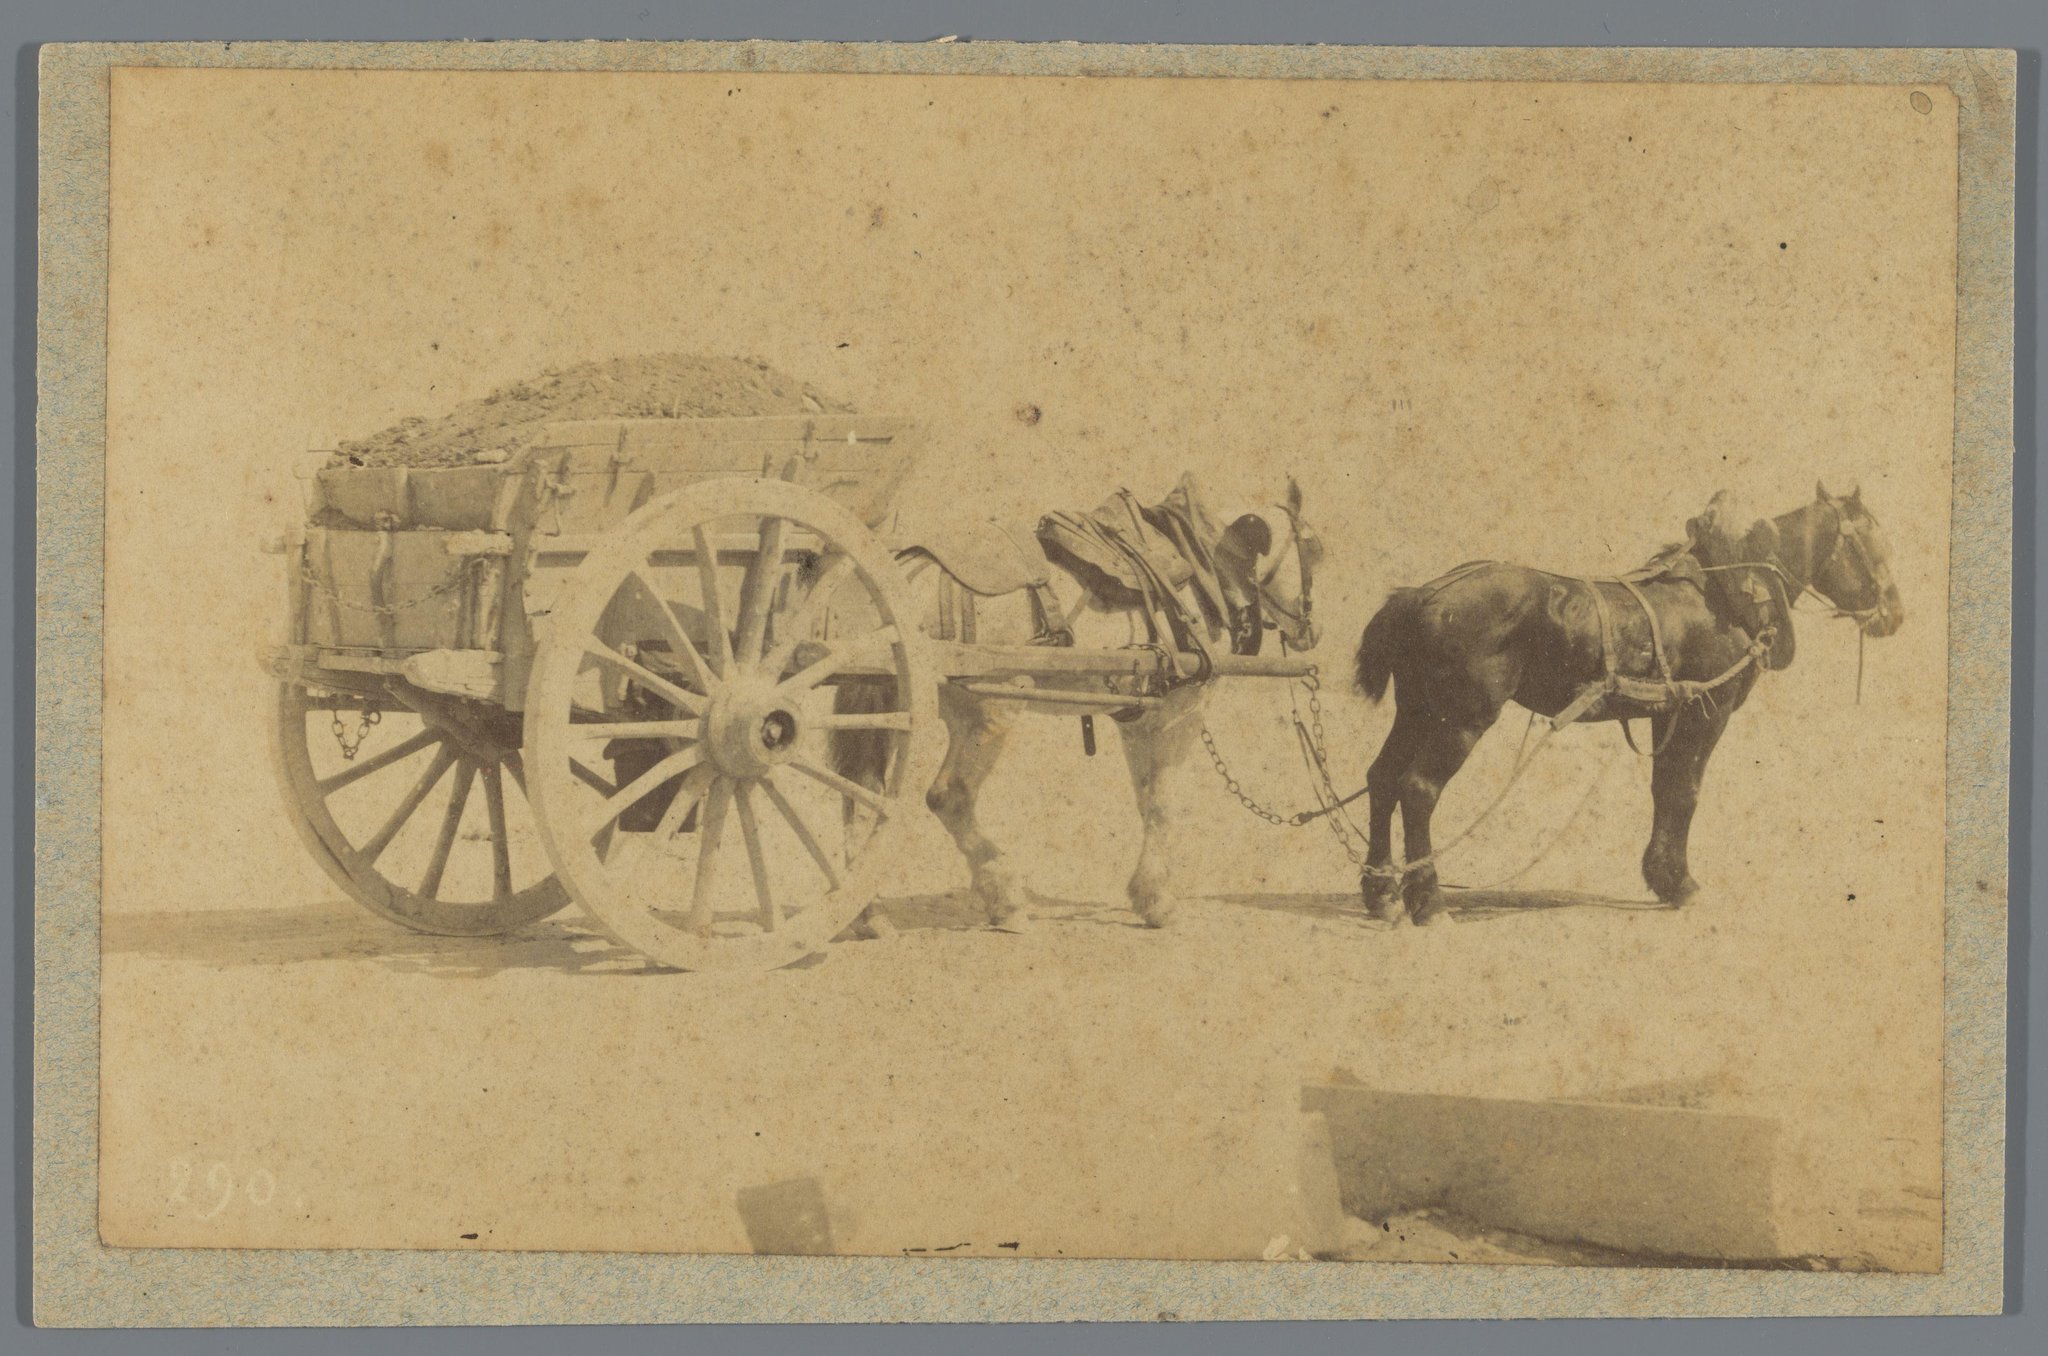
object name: photograph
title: Paarden voor een kar, mogelijk in Frankrijk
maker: Anonymous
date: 1885-1910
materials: cardboard, paper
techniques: albumen print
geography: france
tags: horse, (farm) wagon, freight wagon, cart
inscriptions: number: ‘290’